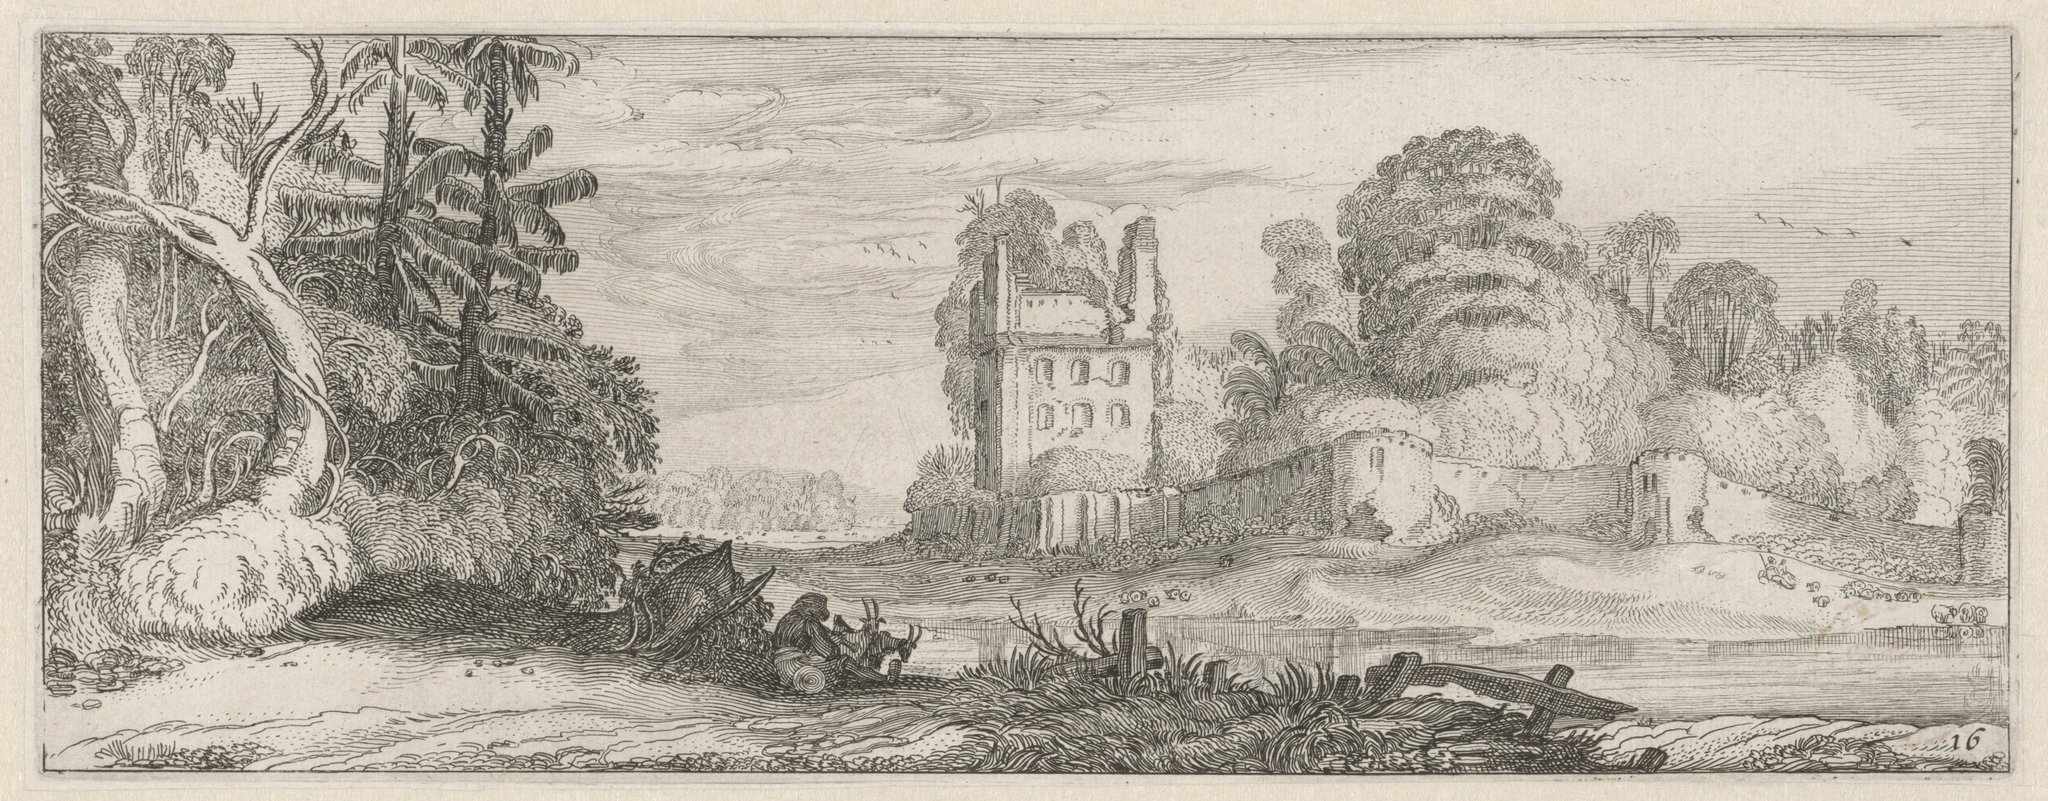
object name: print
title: Amoenissimae aliquot Regiunculae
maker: jan van de velde (ii)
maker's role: draughtsman, painter, print maker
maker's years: 1593-1641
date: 1615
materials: paper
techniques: etching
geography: northern netherlands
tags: herding, herdsman, herdswoman, shepherd, shepherdess, cowherd, etc., fence, wall, paling, landscape with ruins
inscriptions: collector's mark: Lugt 240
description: Gezicht op een ruïne van een huis bij een muur. Op de voorgrond een zittende fluit spelende herder. Zestiende prent uit een serie van achttien.